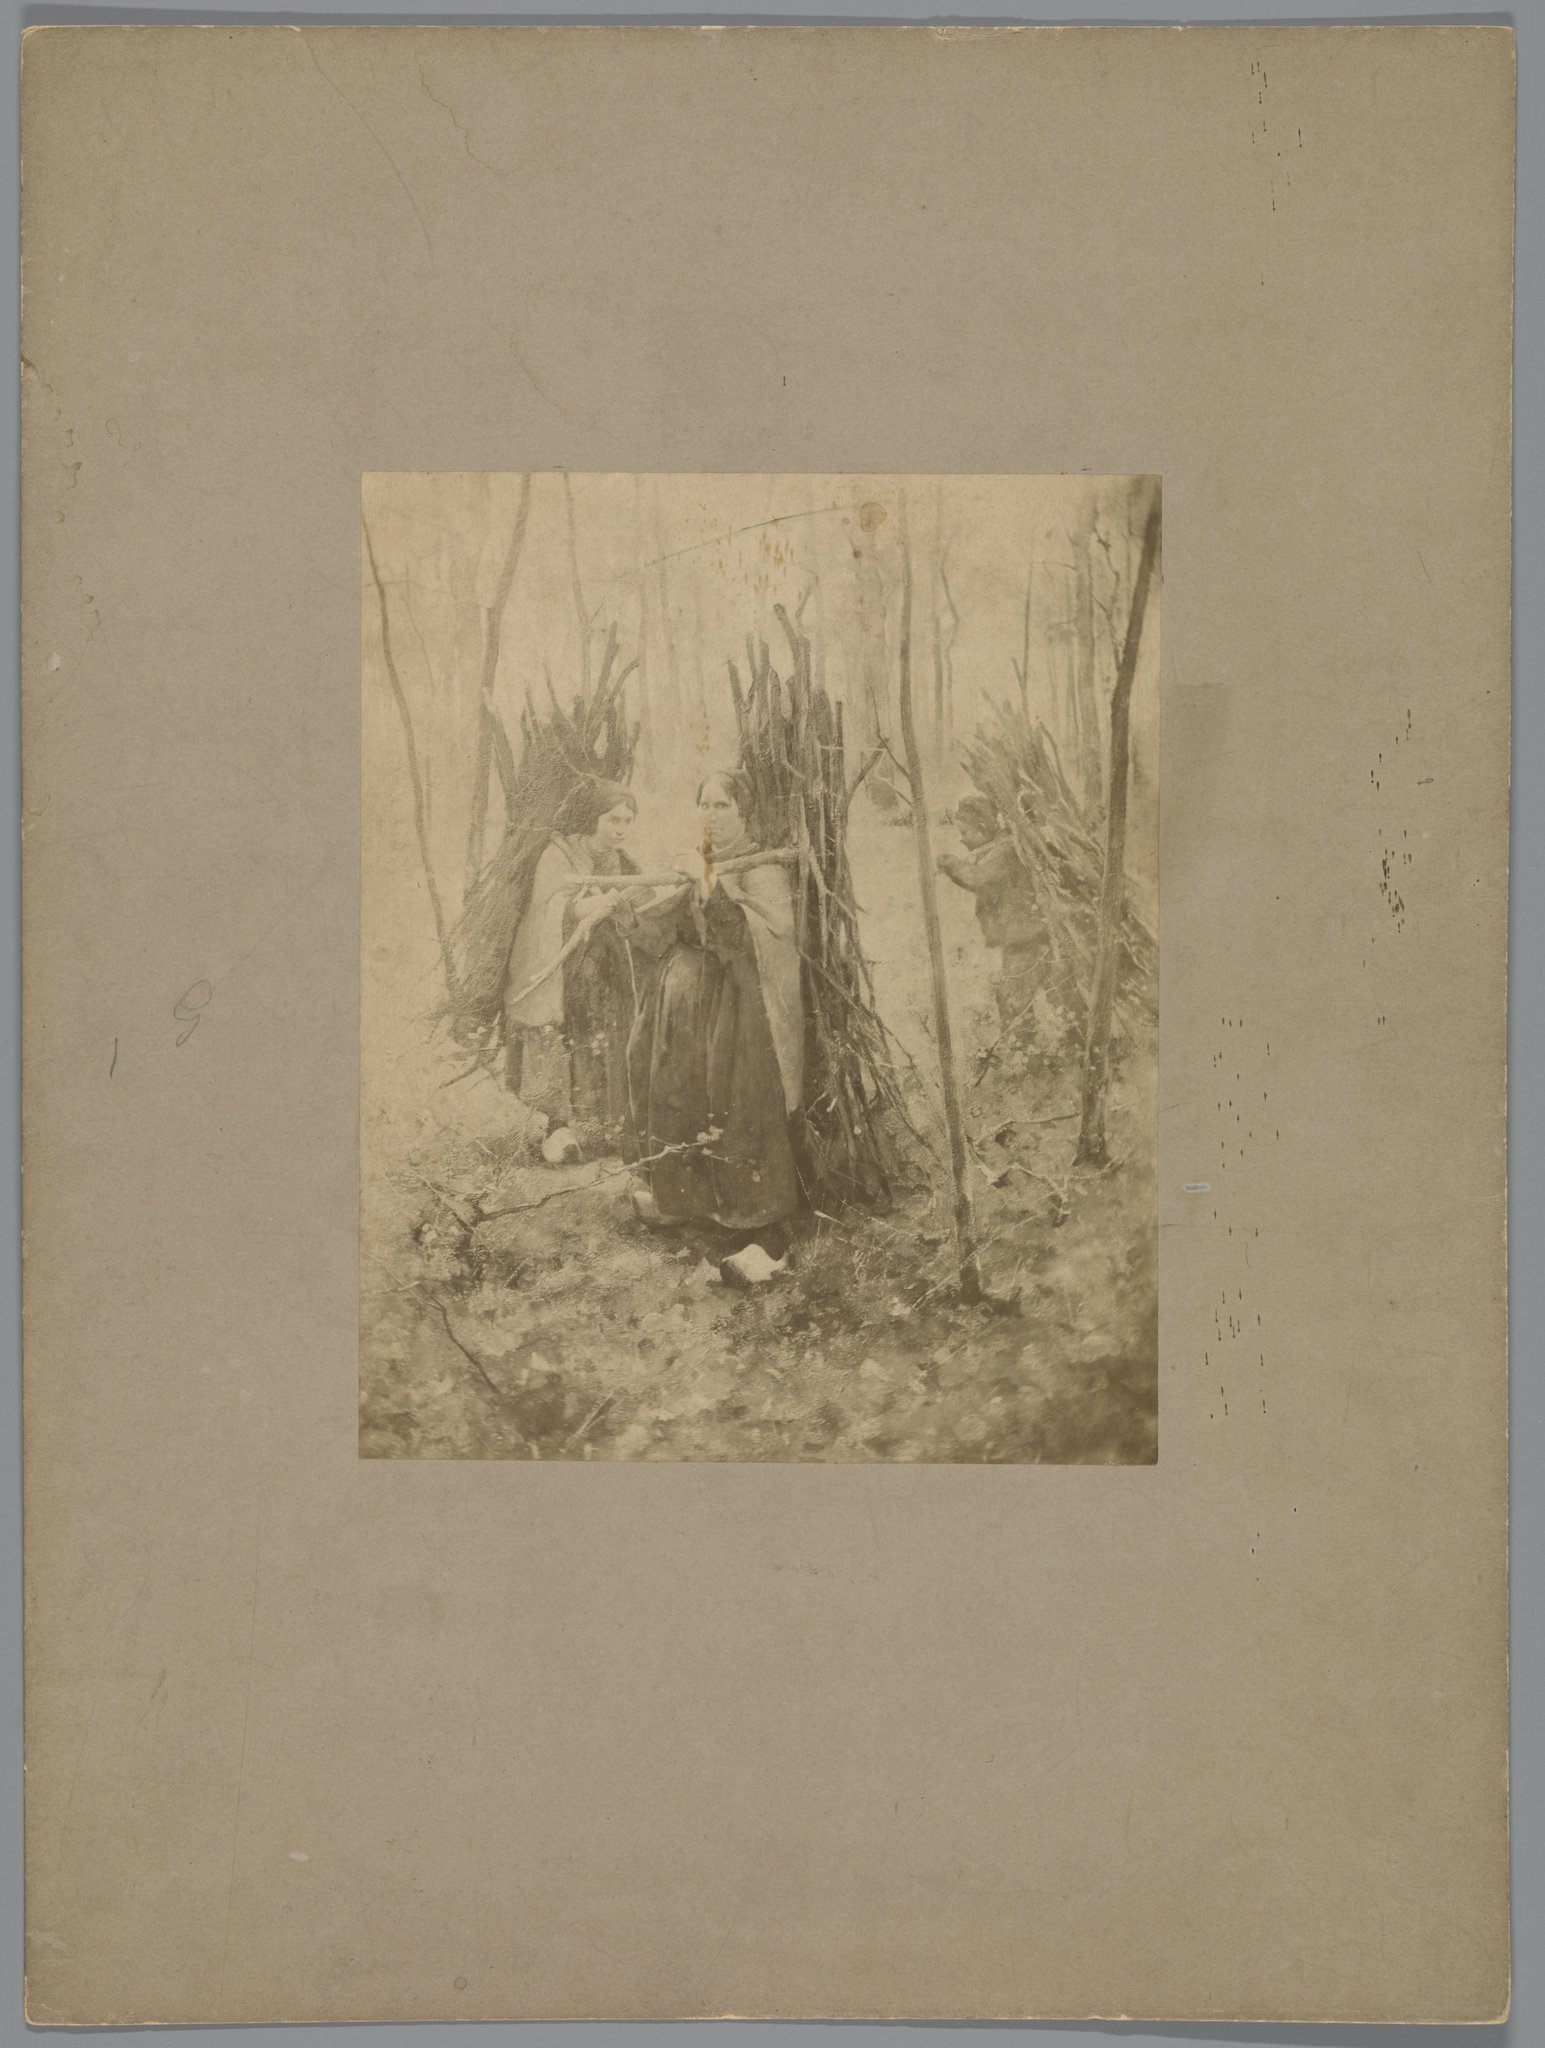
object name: photograph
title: Reproductie naar een schilderij van Willem Witsen van twee vrouwen en een kind met takken op de rug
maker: Anonymous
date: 1860-1915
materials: cardboard, paper, photographic support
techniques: albumen print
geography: netherlands